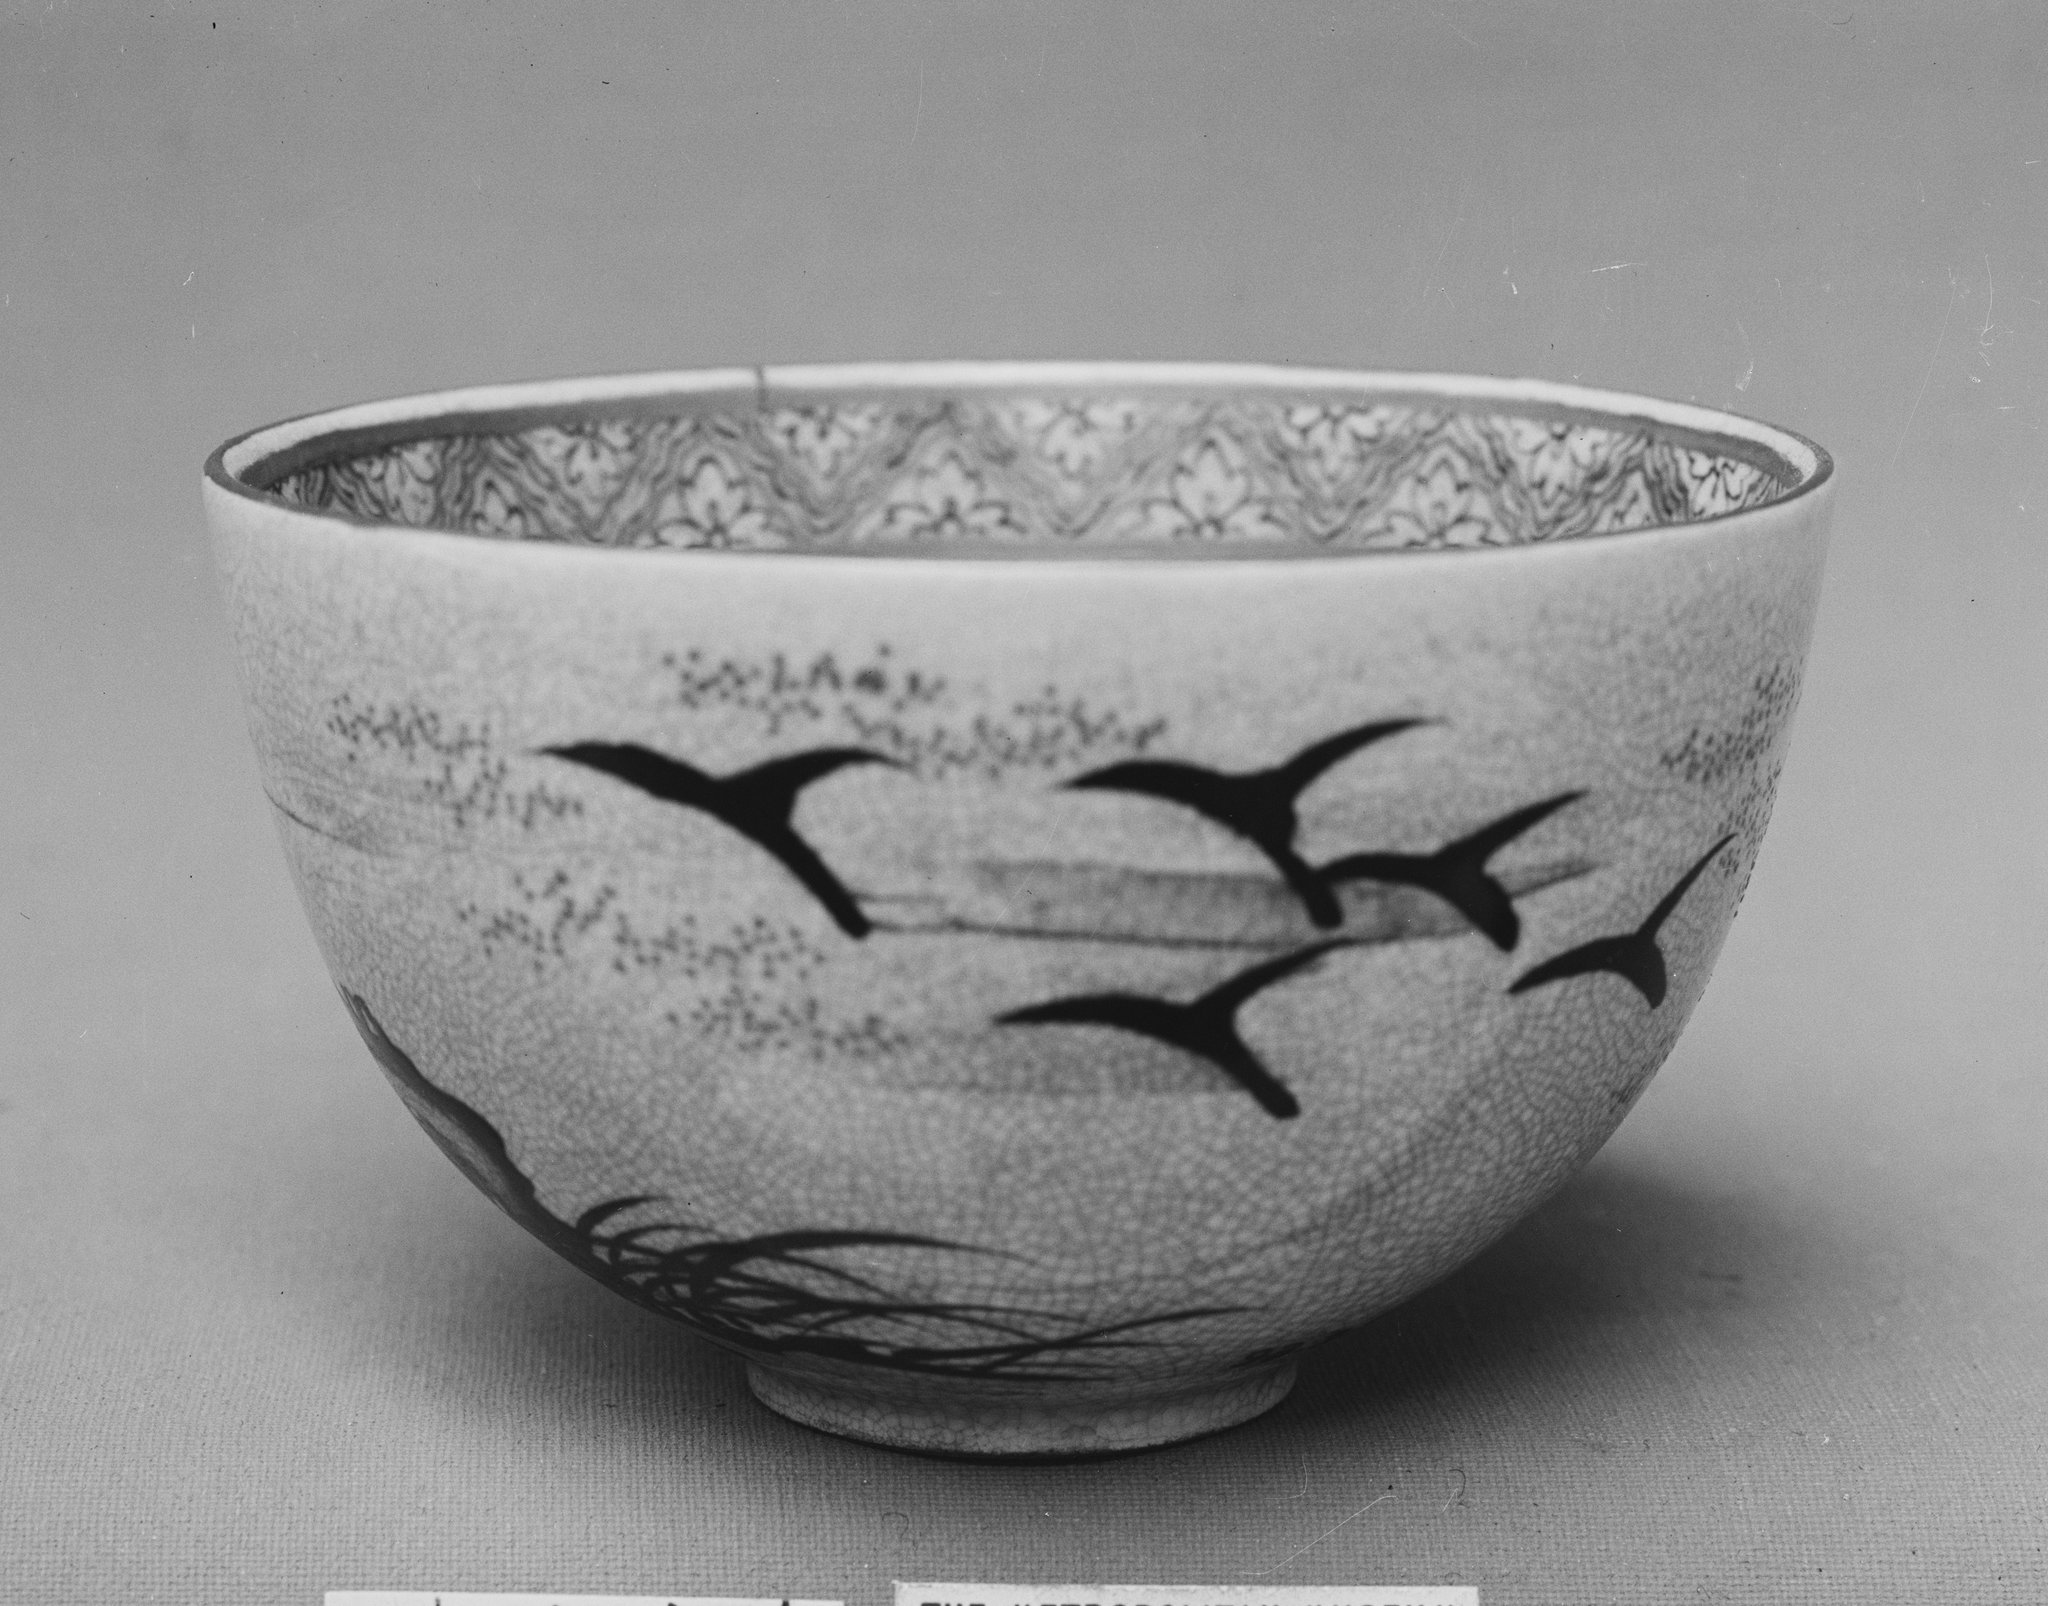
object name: bowl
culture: japanese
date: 1800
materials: enamel, glaze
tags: birds